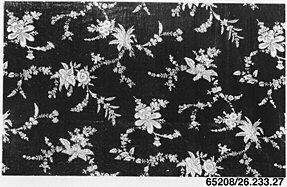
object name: piece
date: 1701-1800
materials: cotton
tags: flowers